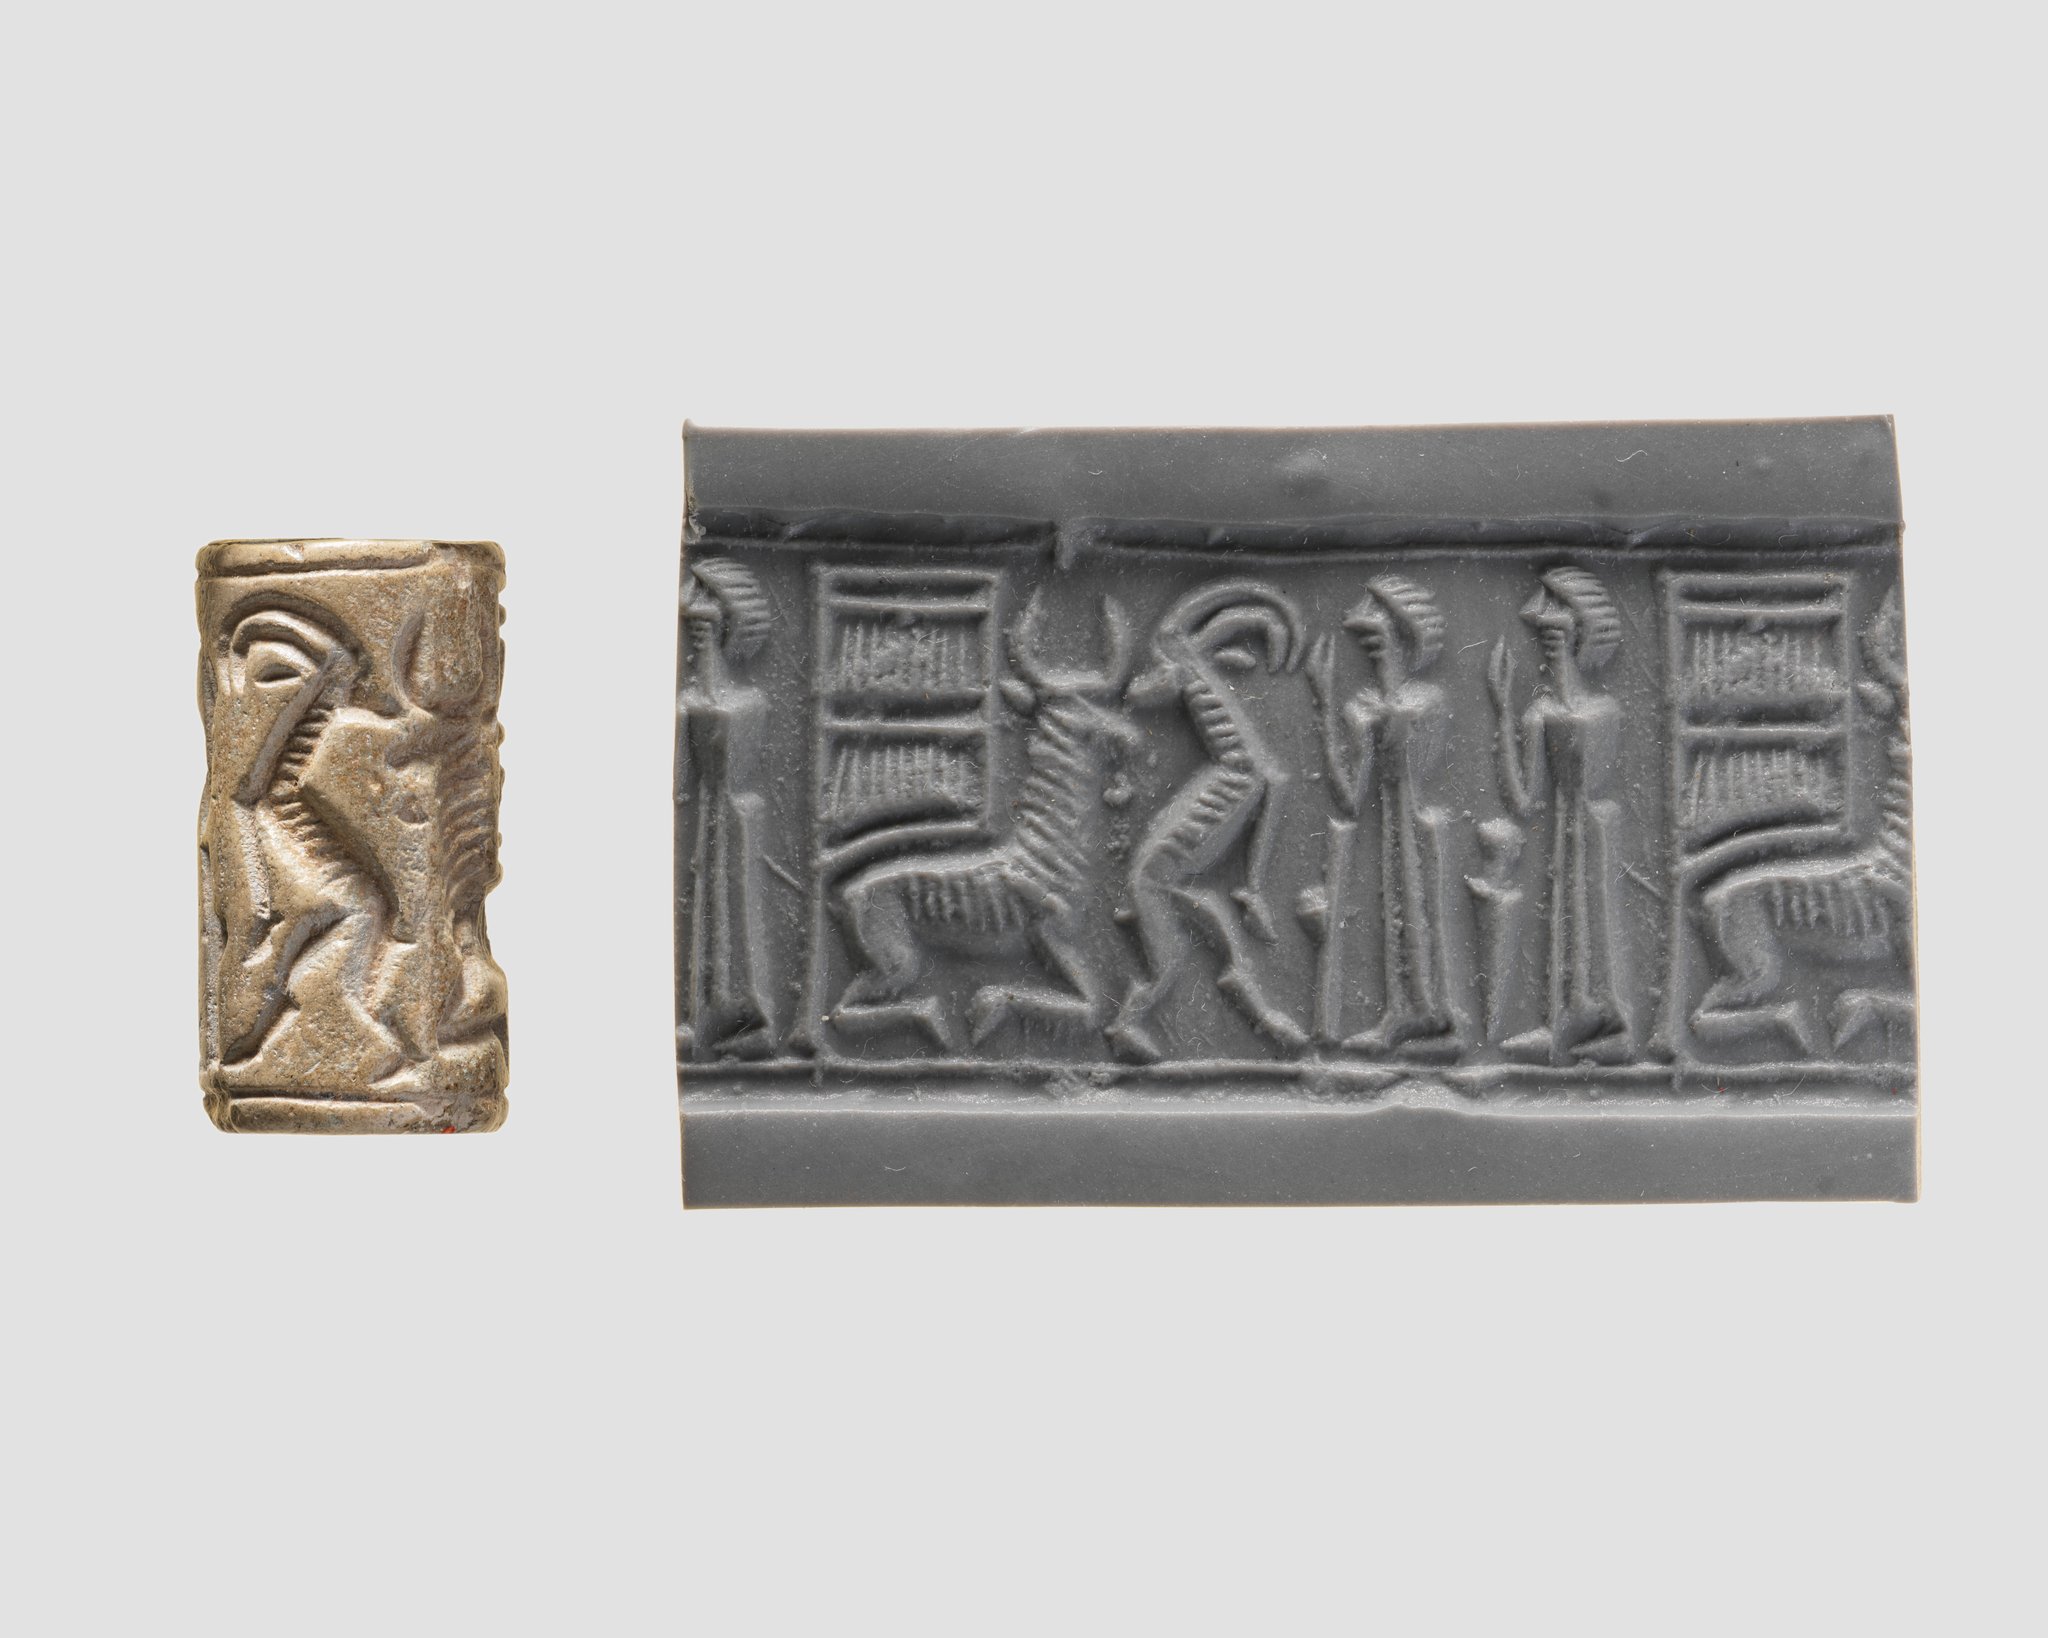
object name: cylinder seal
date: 2000-1668 BCE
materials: limestone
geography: syria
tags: animals